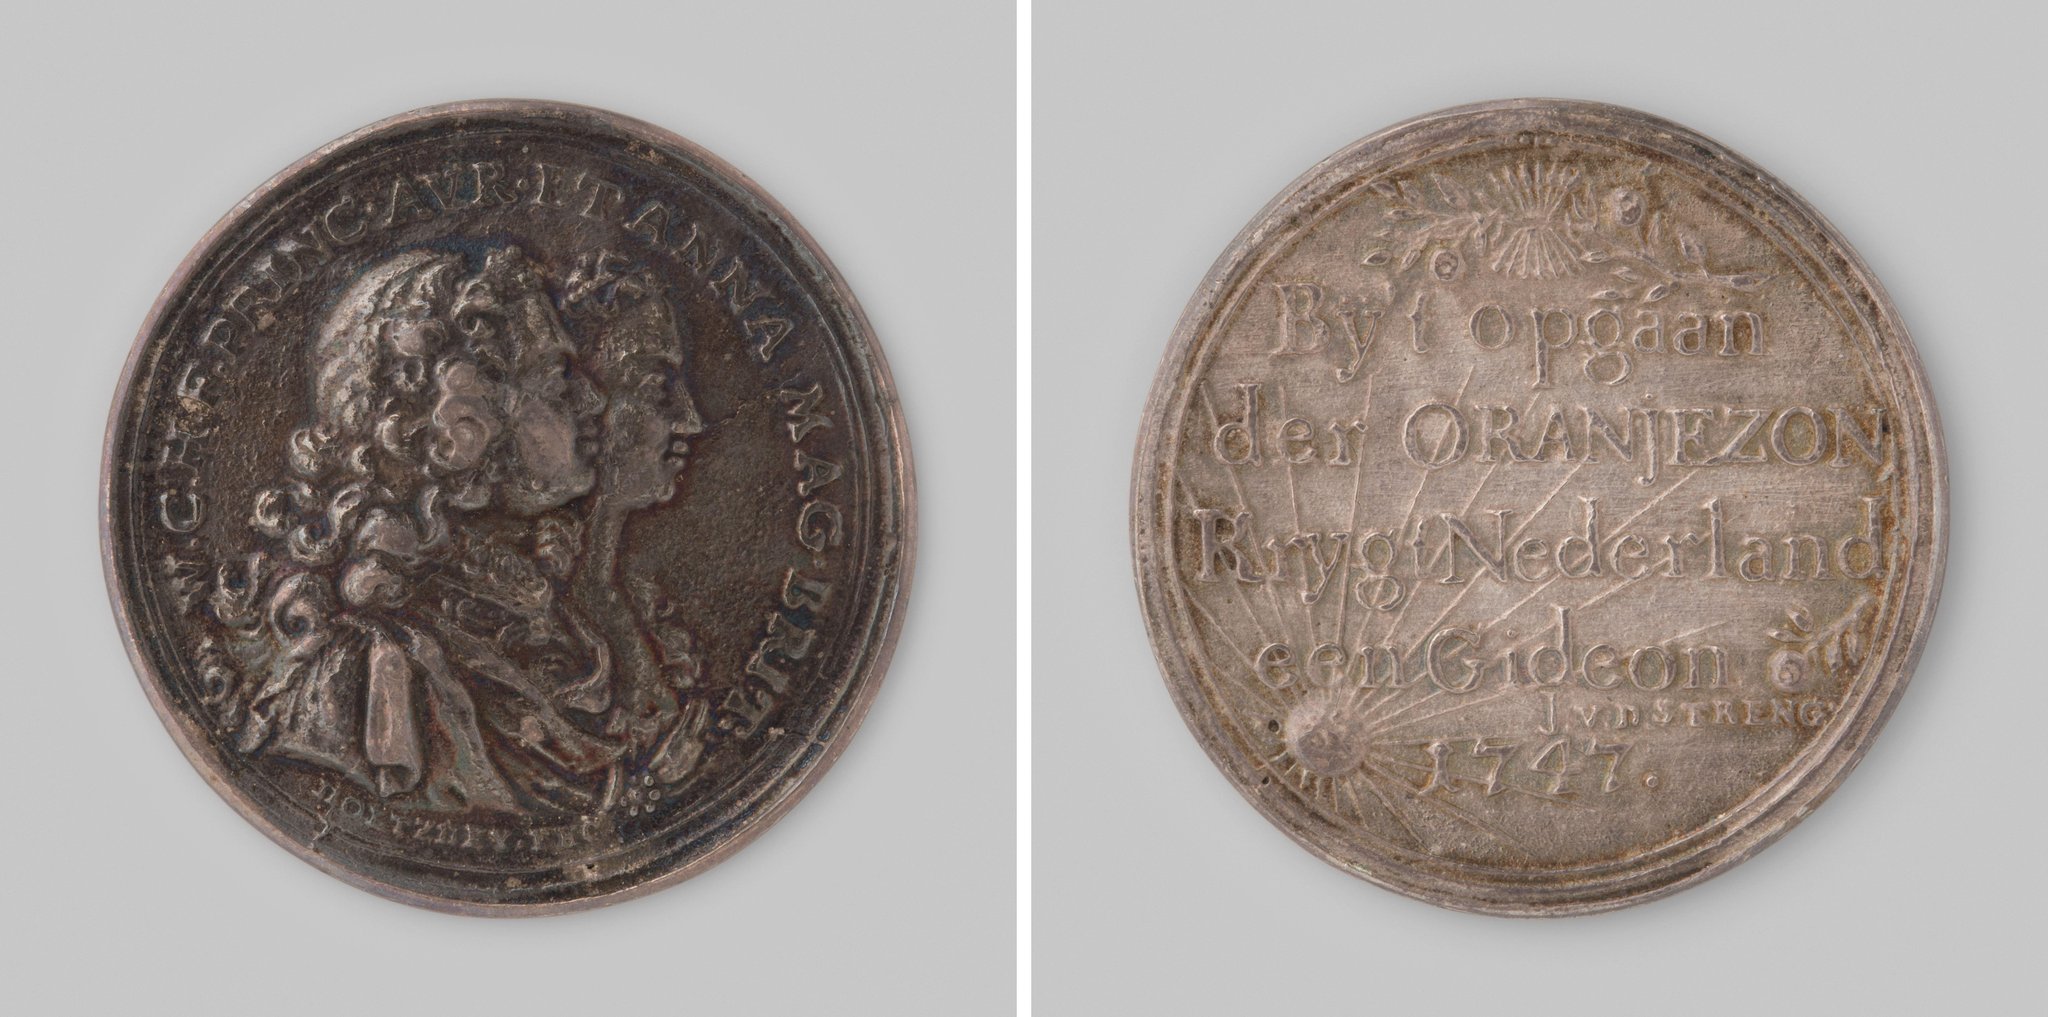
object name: history medal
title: Verkiezing van Willem Karel Hendrik Friso tot stadhouder Willem IV 1747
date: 1747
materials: silver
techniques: casting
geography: amsterdam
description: Gegoten zilveren penning, op de voorzijde de geconjugeerde borstbeelden van Willem en Anna naar rechts met omschrift, op de keerzijde vijf regels tekst, bovenaan een oranjetak met pijlenbundel en onderaan een opgaande zon.